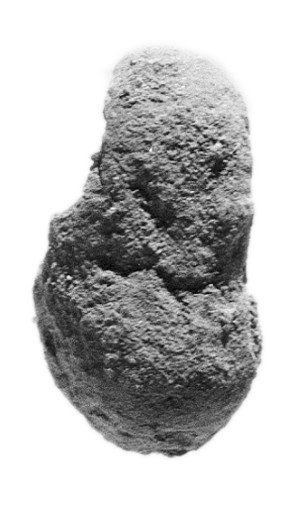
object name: sealing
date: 1981-1640 BCE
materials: mud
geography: egypt